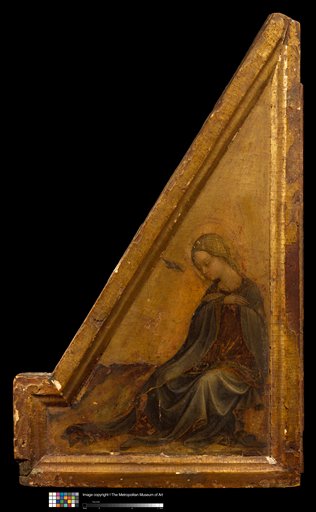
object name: frame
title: Panel from a triptych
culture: tuscan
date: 1440-1449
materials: gilt, wood